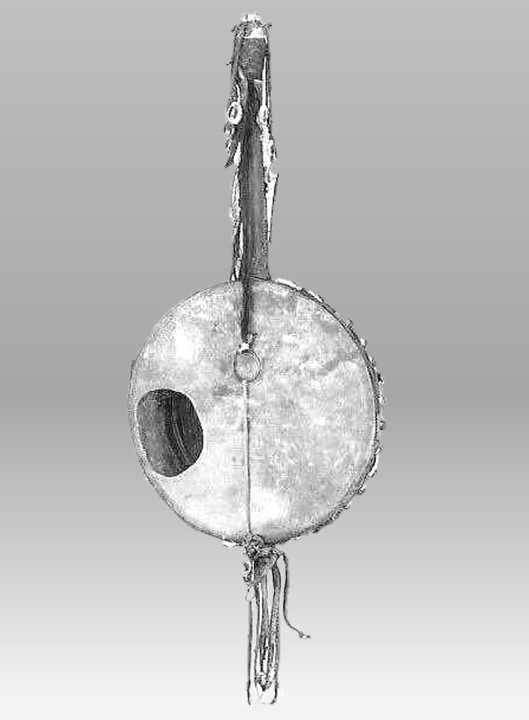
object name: goge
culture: egyptian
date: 1867-1900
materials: brass, shell, velvet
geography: egypt